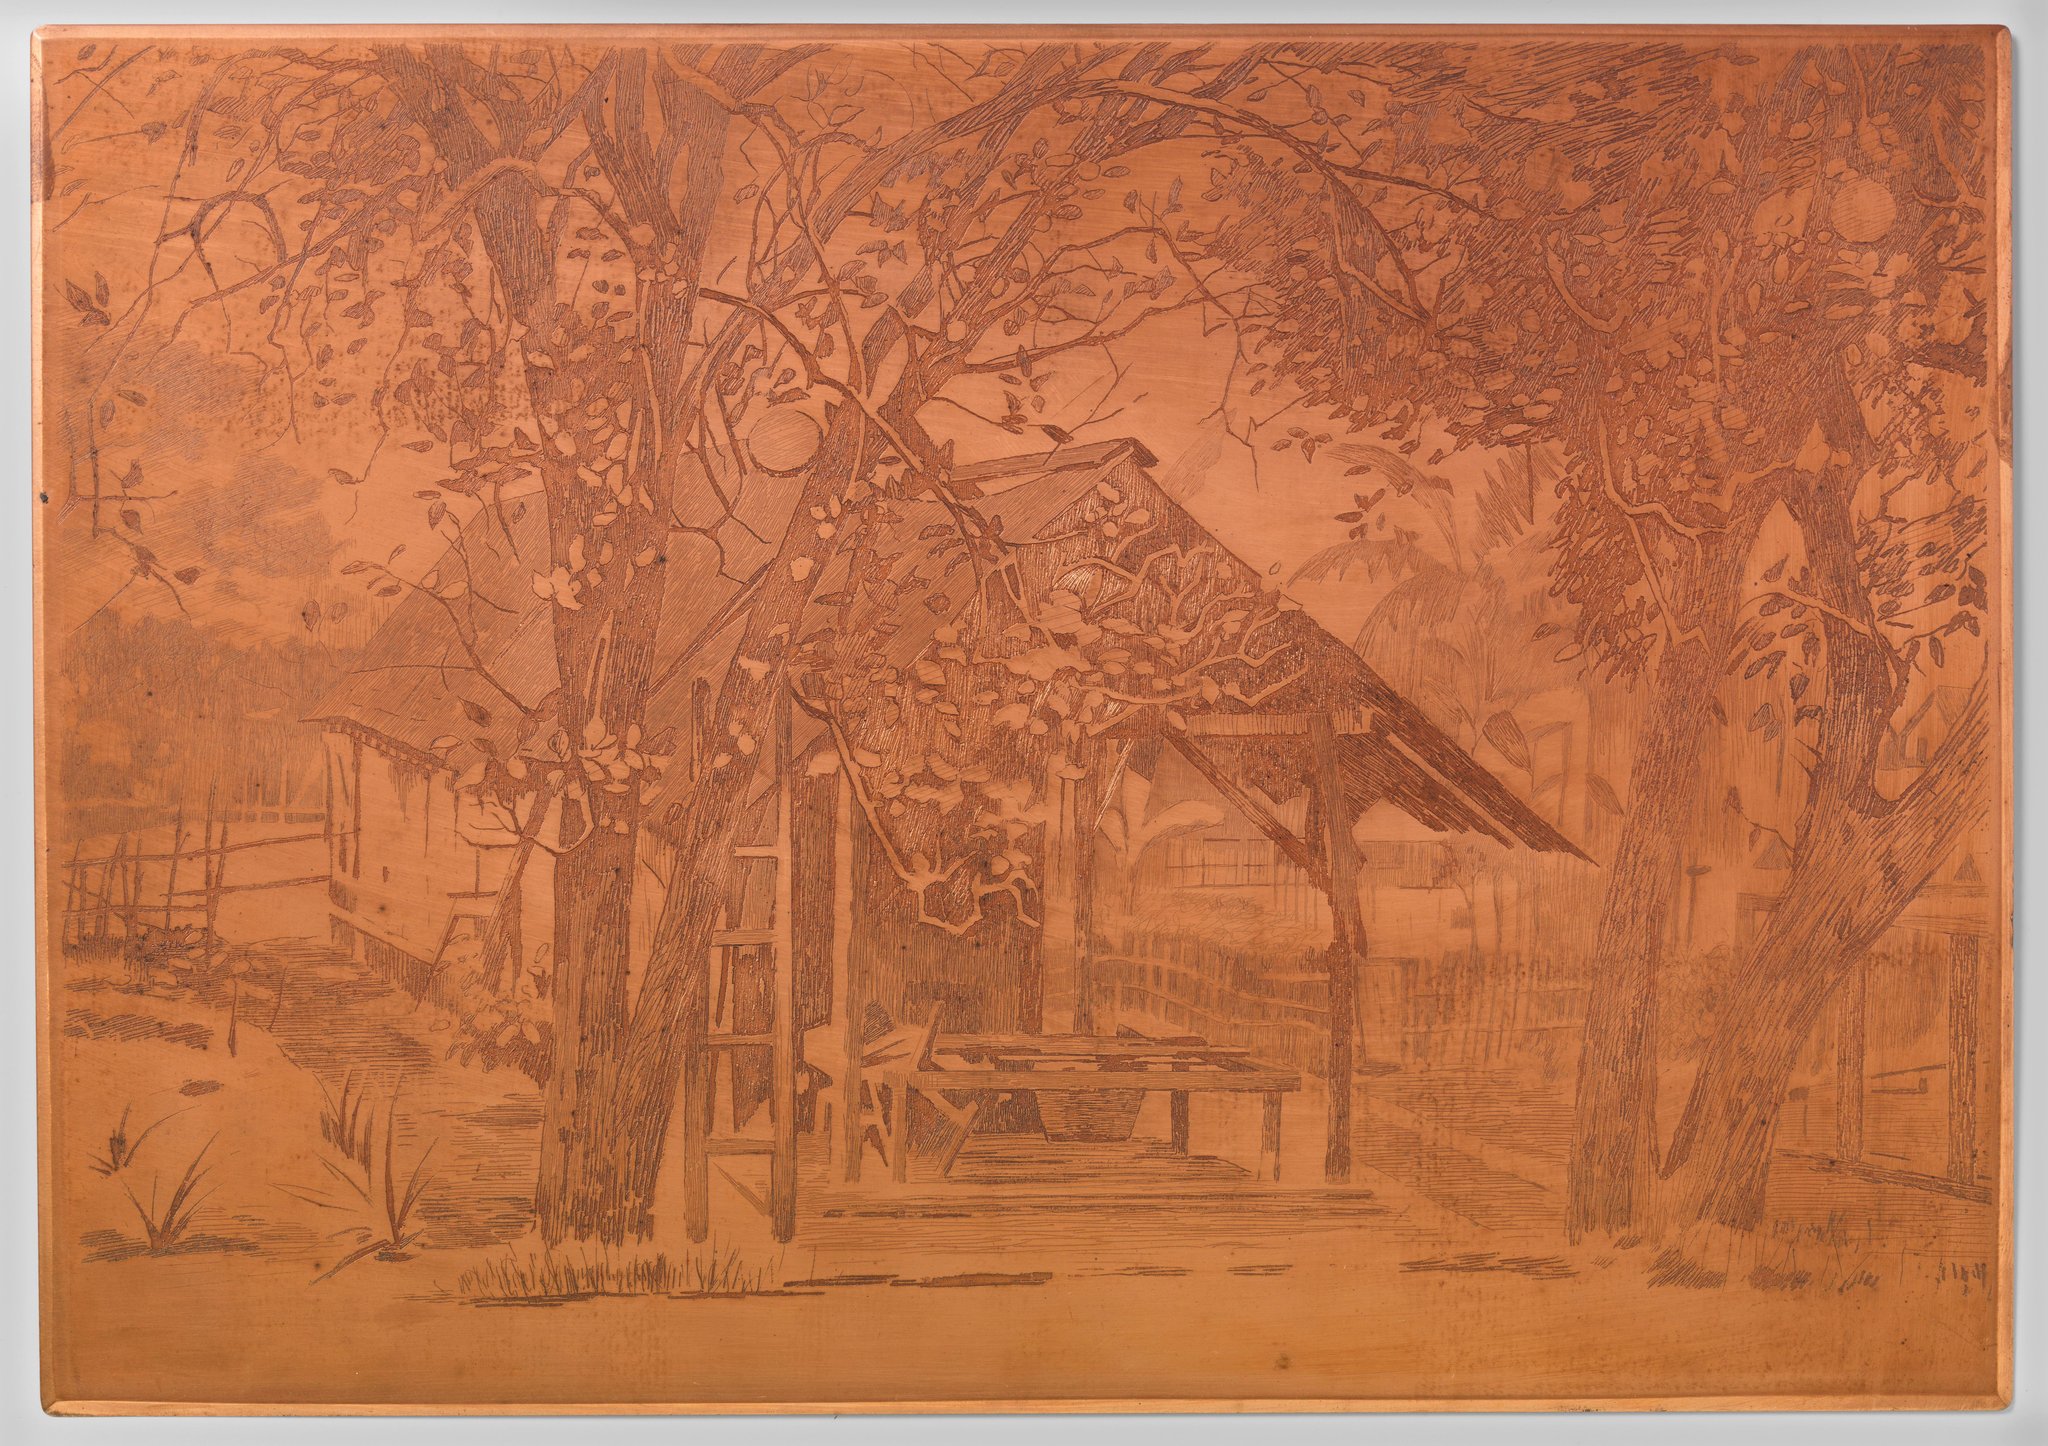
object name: copper plate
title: Bijgebouwen, Gambar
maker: willem witsen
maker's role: draughtsman, painter, print maker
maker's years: 1860-1923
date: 1921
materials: copper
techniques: etching